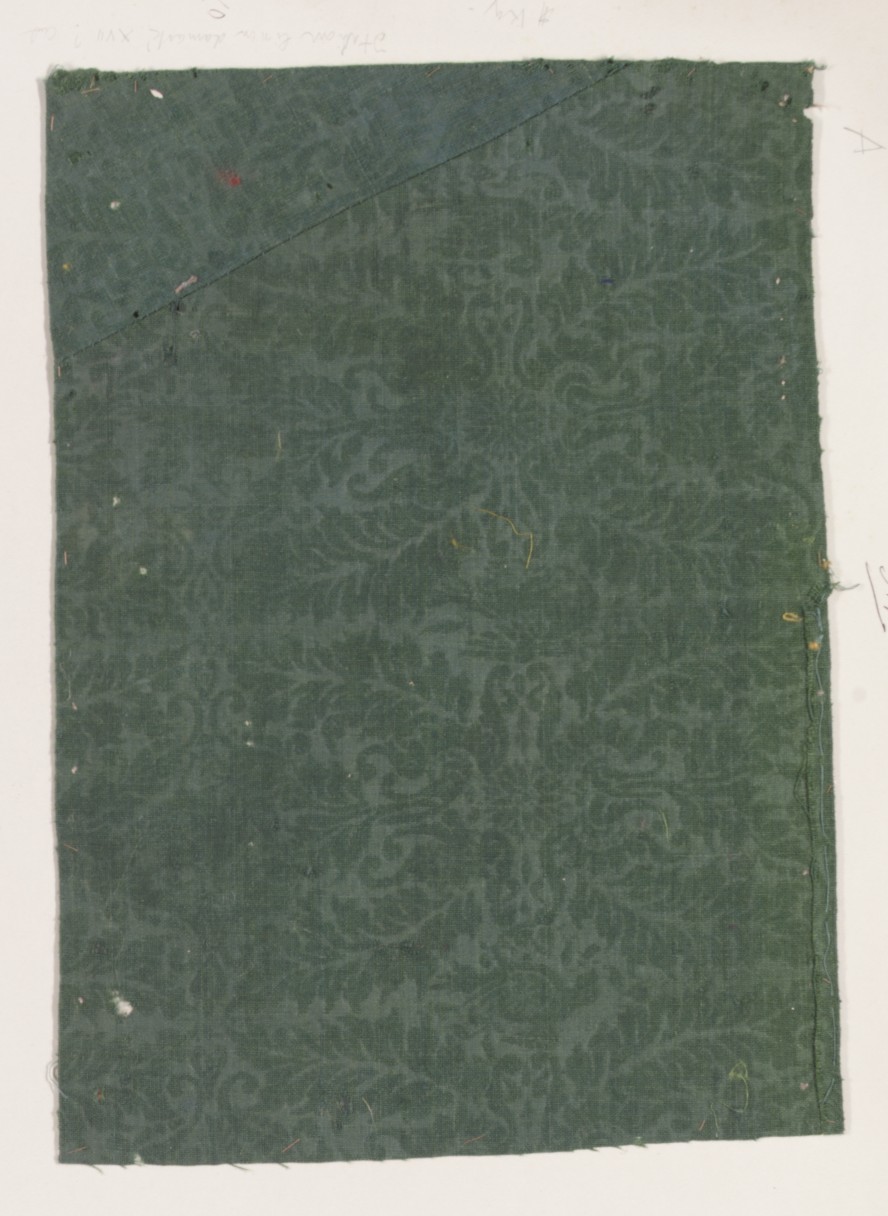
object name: fragment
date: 1601-1700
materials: wool